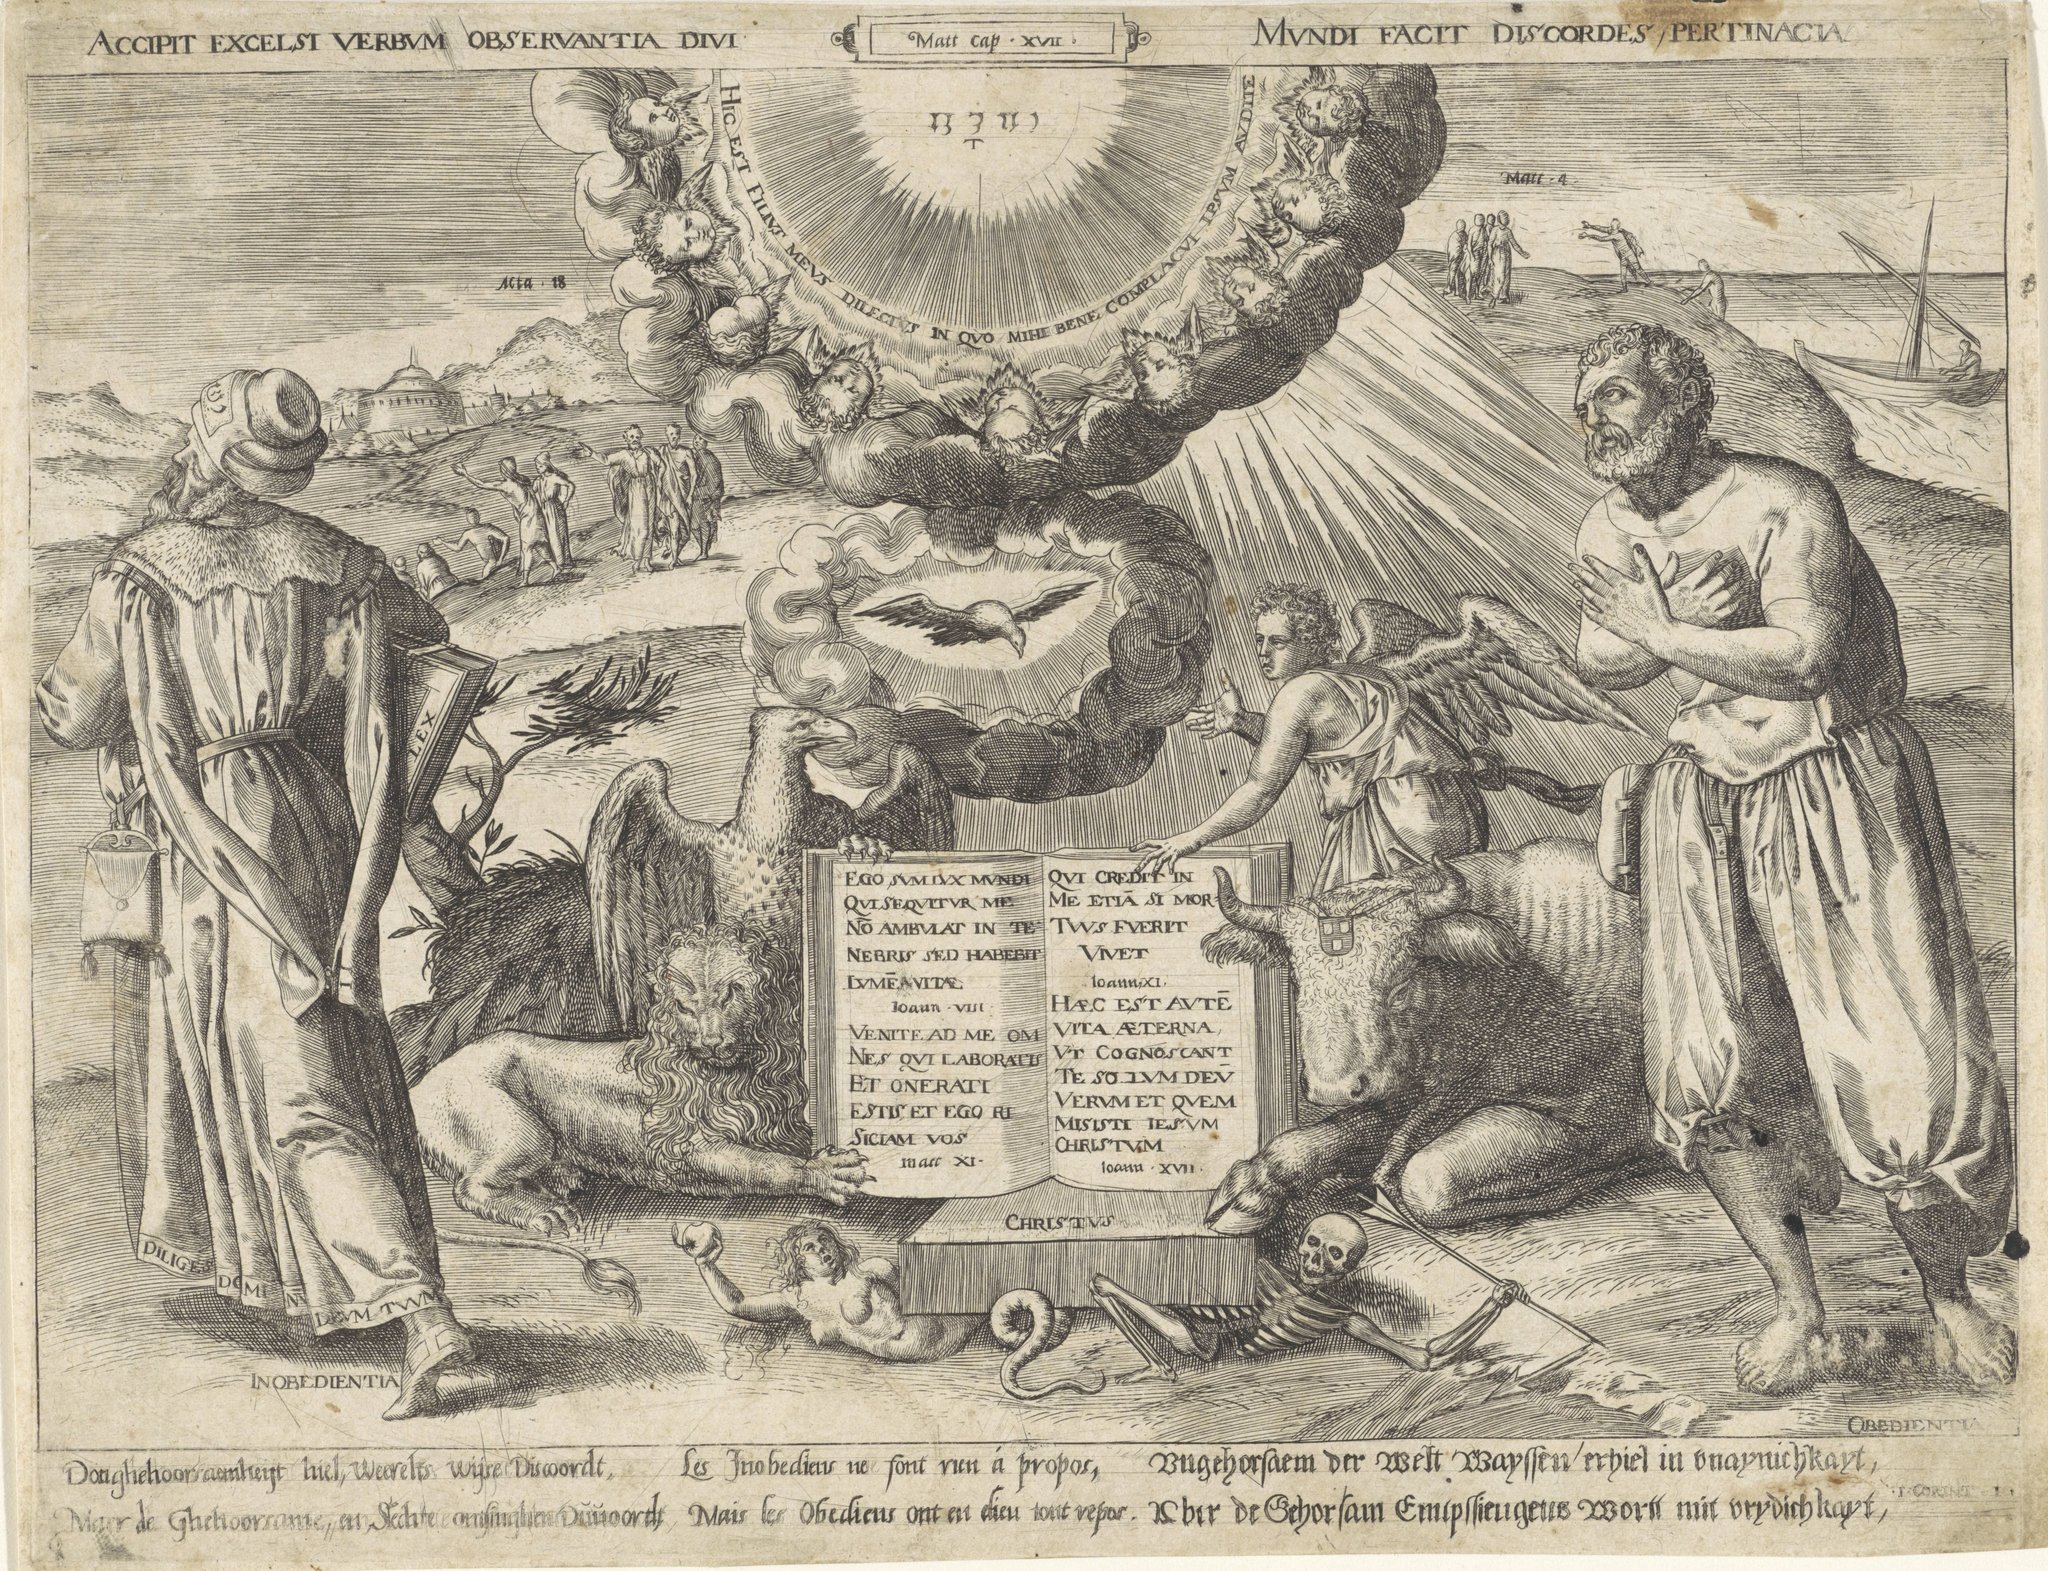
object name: print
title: Ongehoorzaamheid en Gehoorzaamheid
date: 1579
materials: paper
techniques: engraving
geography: antwerp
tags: the second missionary journey of paul (acts 16 - 18:21), the serpent tries to persuade eve to take some of the fruit (usually an apple) (+ variant), obedience; 'obedienza' (ripa) (+ personification), death as skeleton, the four symbols of the evangelists, 'the apocalyptic beasts', calling of the apostles, tetragram (in roman or hebrew script) ~ symbol of god the father, the bible as a book, disobedience, contumacy, insubordination; 'inubidienza' (ripa) (+ personification), holy ghost represented as a dove (in flames)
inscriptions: collector's mark: Lugt 2228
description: In het midden een opengeslagen bijbel met Bijbelcitaten in het Latijn op een steen gemerkt "Christus". De duivelse slang van de zondeval en de Dood als skelet worden door de steen verpletterd. De bijbel is omringd door de symbolen van de vier evangelisten. Daarboven de duif van de Heilige Geest en aan de hemel het tetragram als symbool van God de Vader, omringd door cherubijnen. Links de mannelijke personificatie van Ongehoorzaamheid (Inobedientia), op de rug gezien, met een boek onder de arm. Rechts de mannelijke personificatie van Gehoorzaamheid (Obedientia), zijn armen gekruist voor de borst, die omhoog kijkt naar het tetragram. Op de achtergrond zijn twee bijbelse scènes verbeeld. Links probeert de heilige Paulus de Joden te bekeren (Hand 18). Rechts de roeping van vier apostelen door Christus (Mat. 4). Het bovenschrift van de prent is een Bijbelcitaat uit Mat. 17 in het Latijn. In de marge een tweeregelig Bijbelcitaat uit 1 Kor. 1 in het Nederlands, het Frans en het Duits.